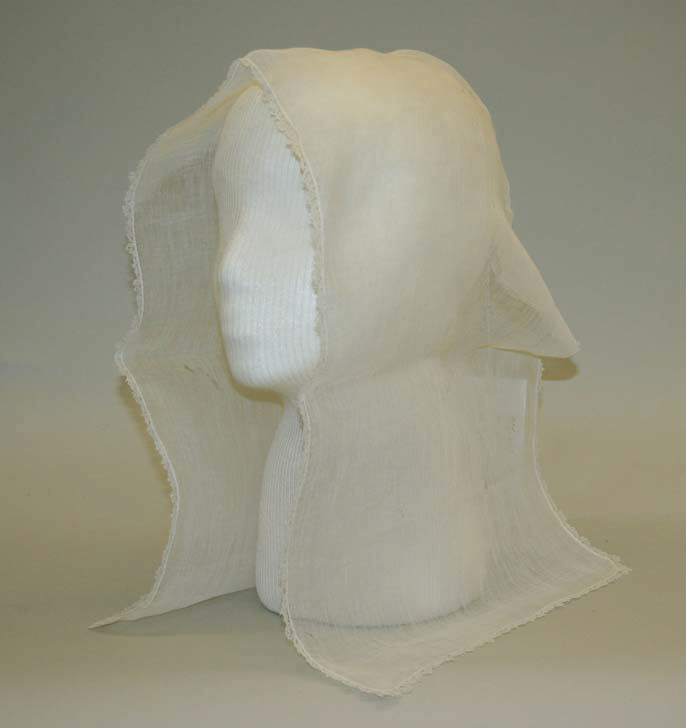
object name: hood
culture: british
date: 1640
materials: cotton